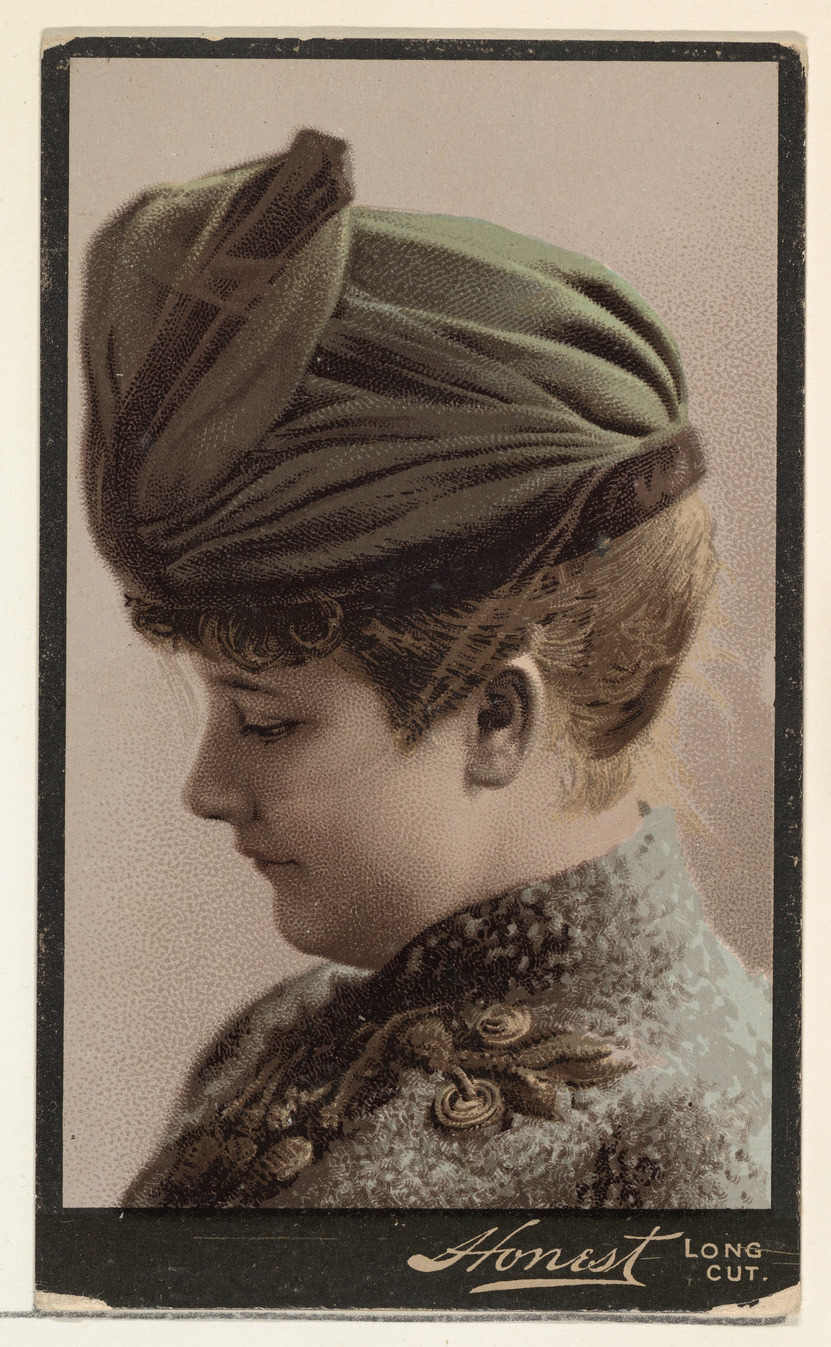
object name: print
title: Actress wearing green cloth turban, from Stars of the Stage, Third Series (N131) issued by Duke Sons & Co. to promote Honest Long Cut Tobacco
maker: w. duke, sons & co.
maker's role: publisher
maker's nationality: american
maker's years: 1870-1920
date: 1891-1892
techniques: color lithograph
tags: women,actresses